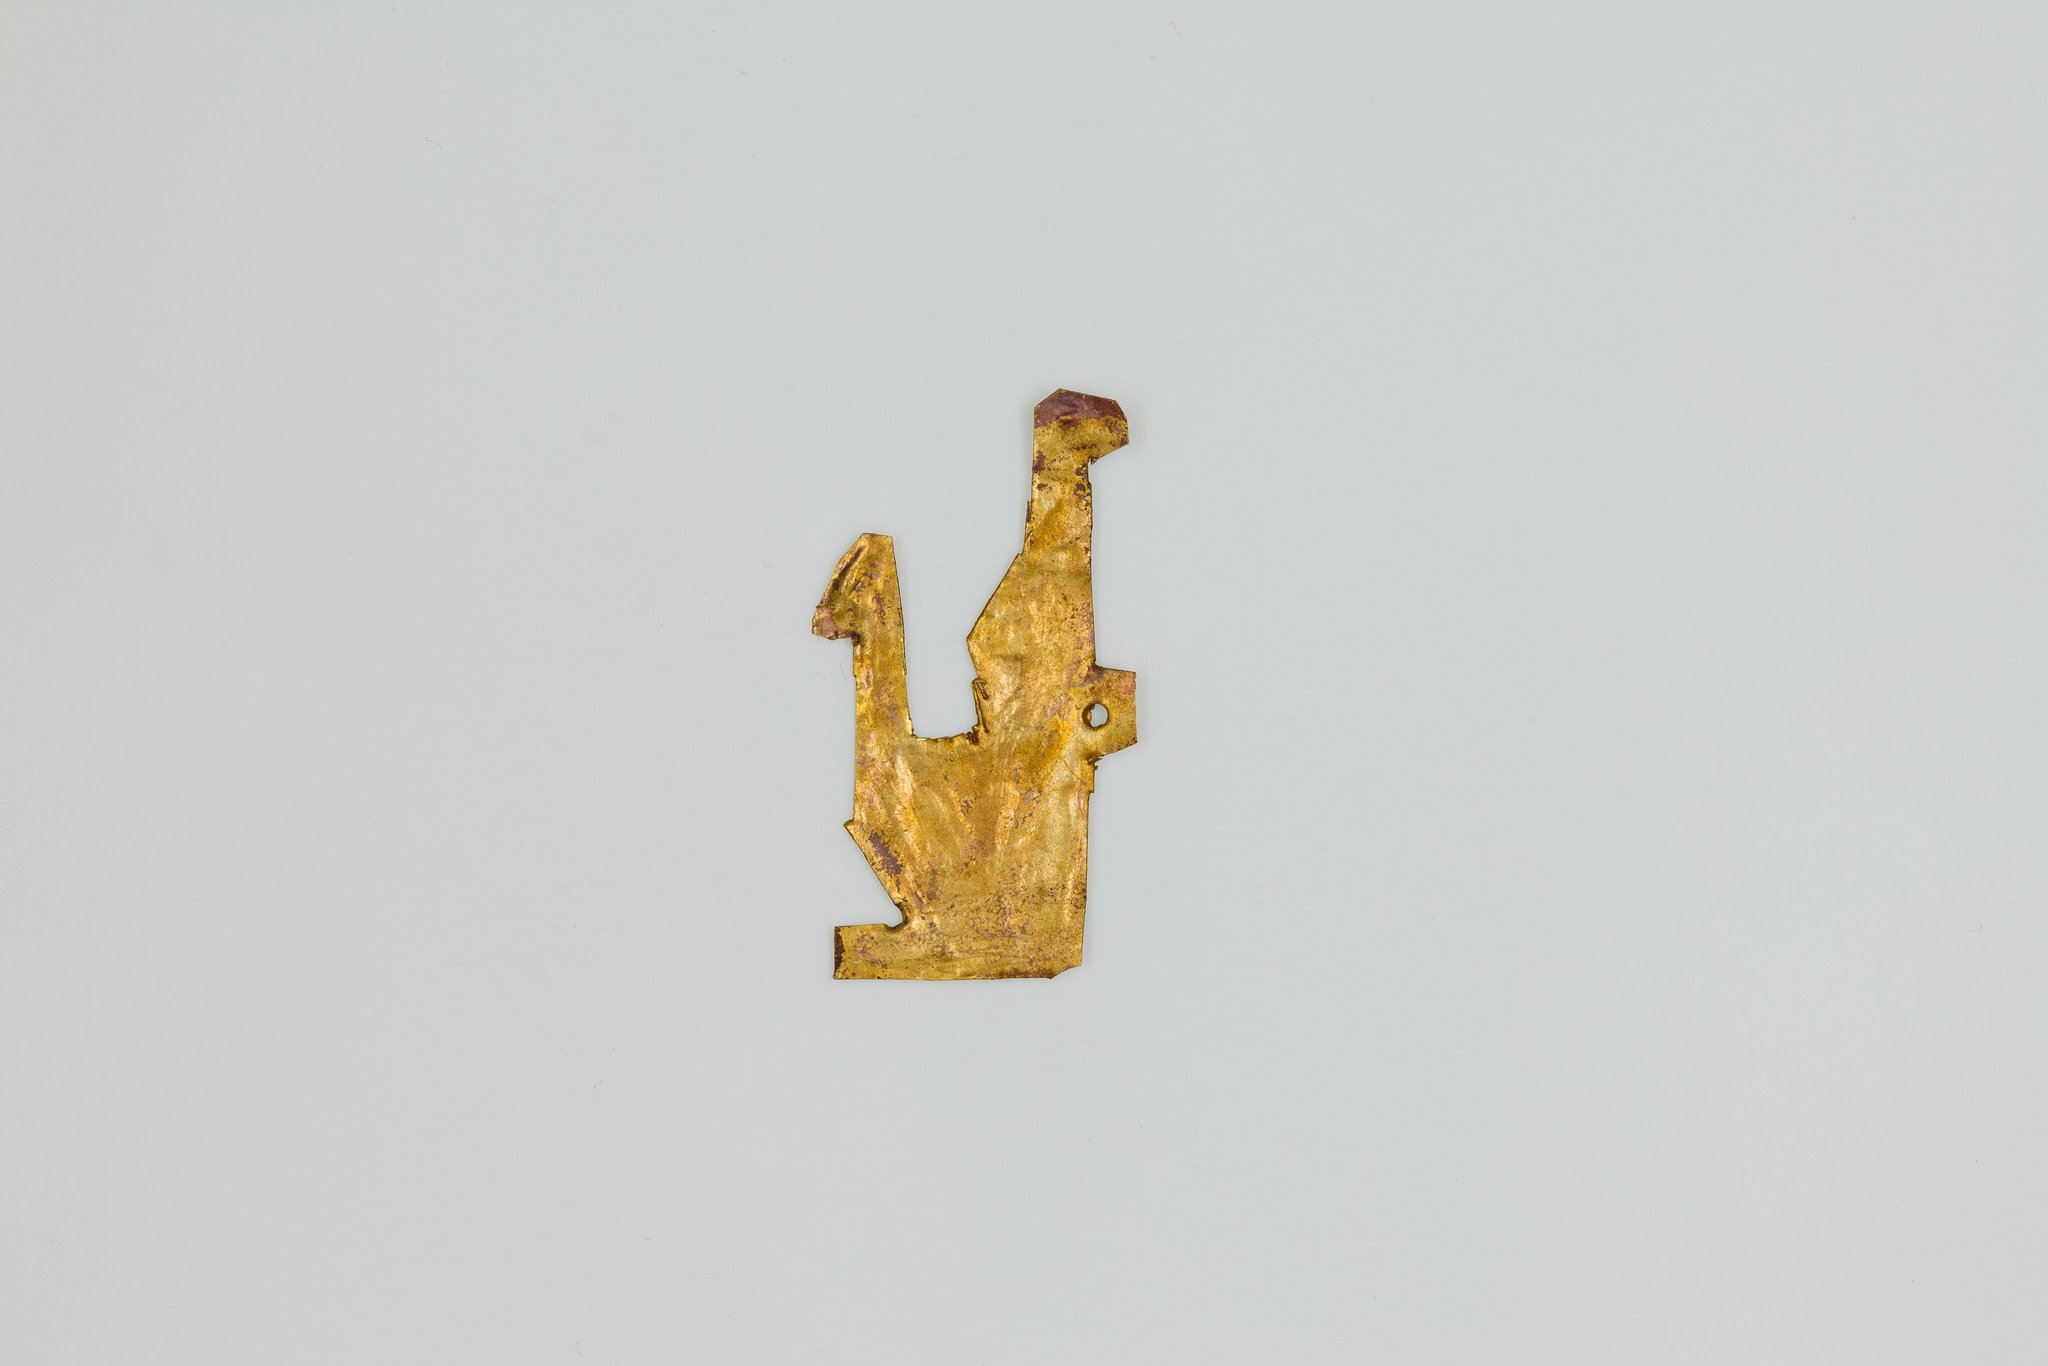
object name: amulet, maat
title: Maat amulet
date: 664-380 BCE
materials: gold